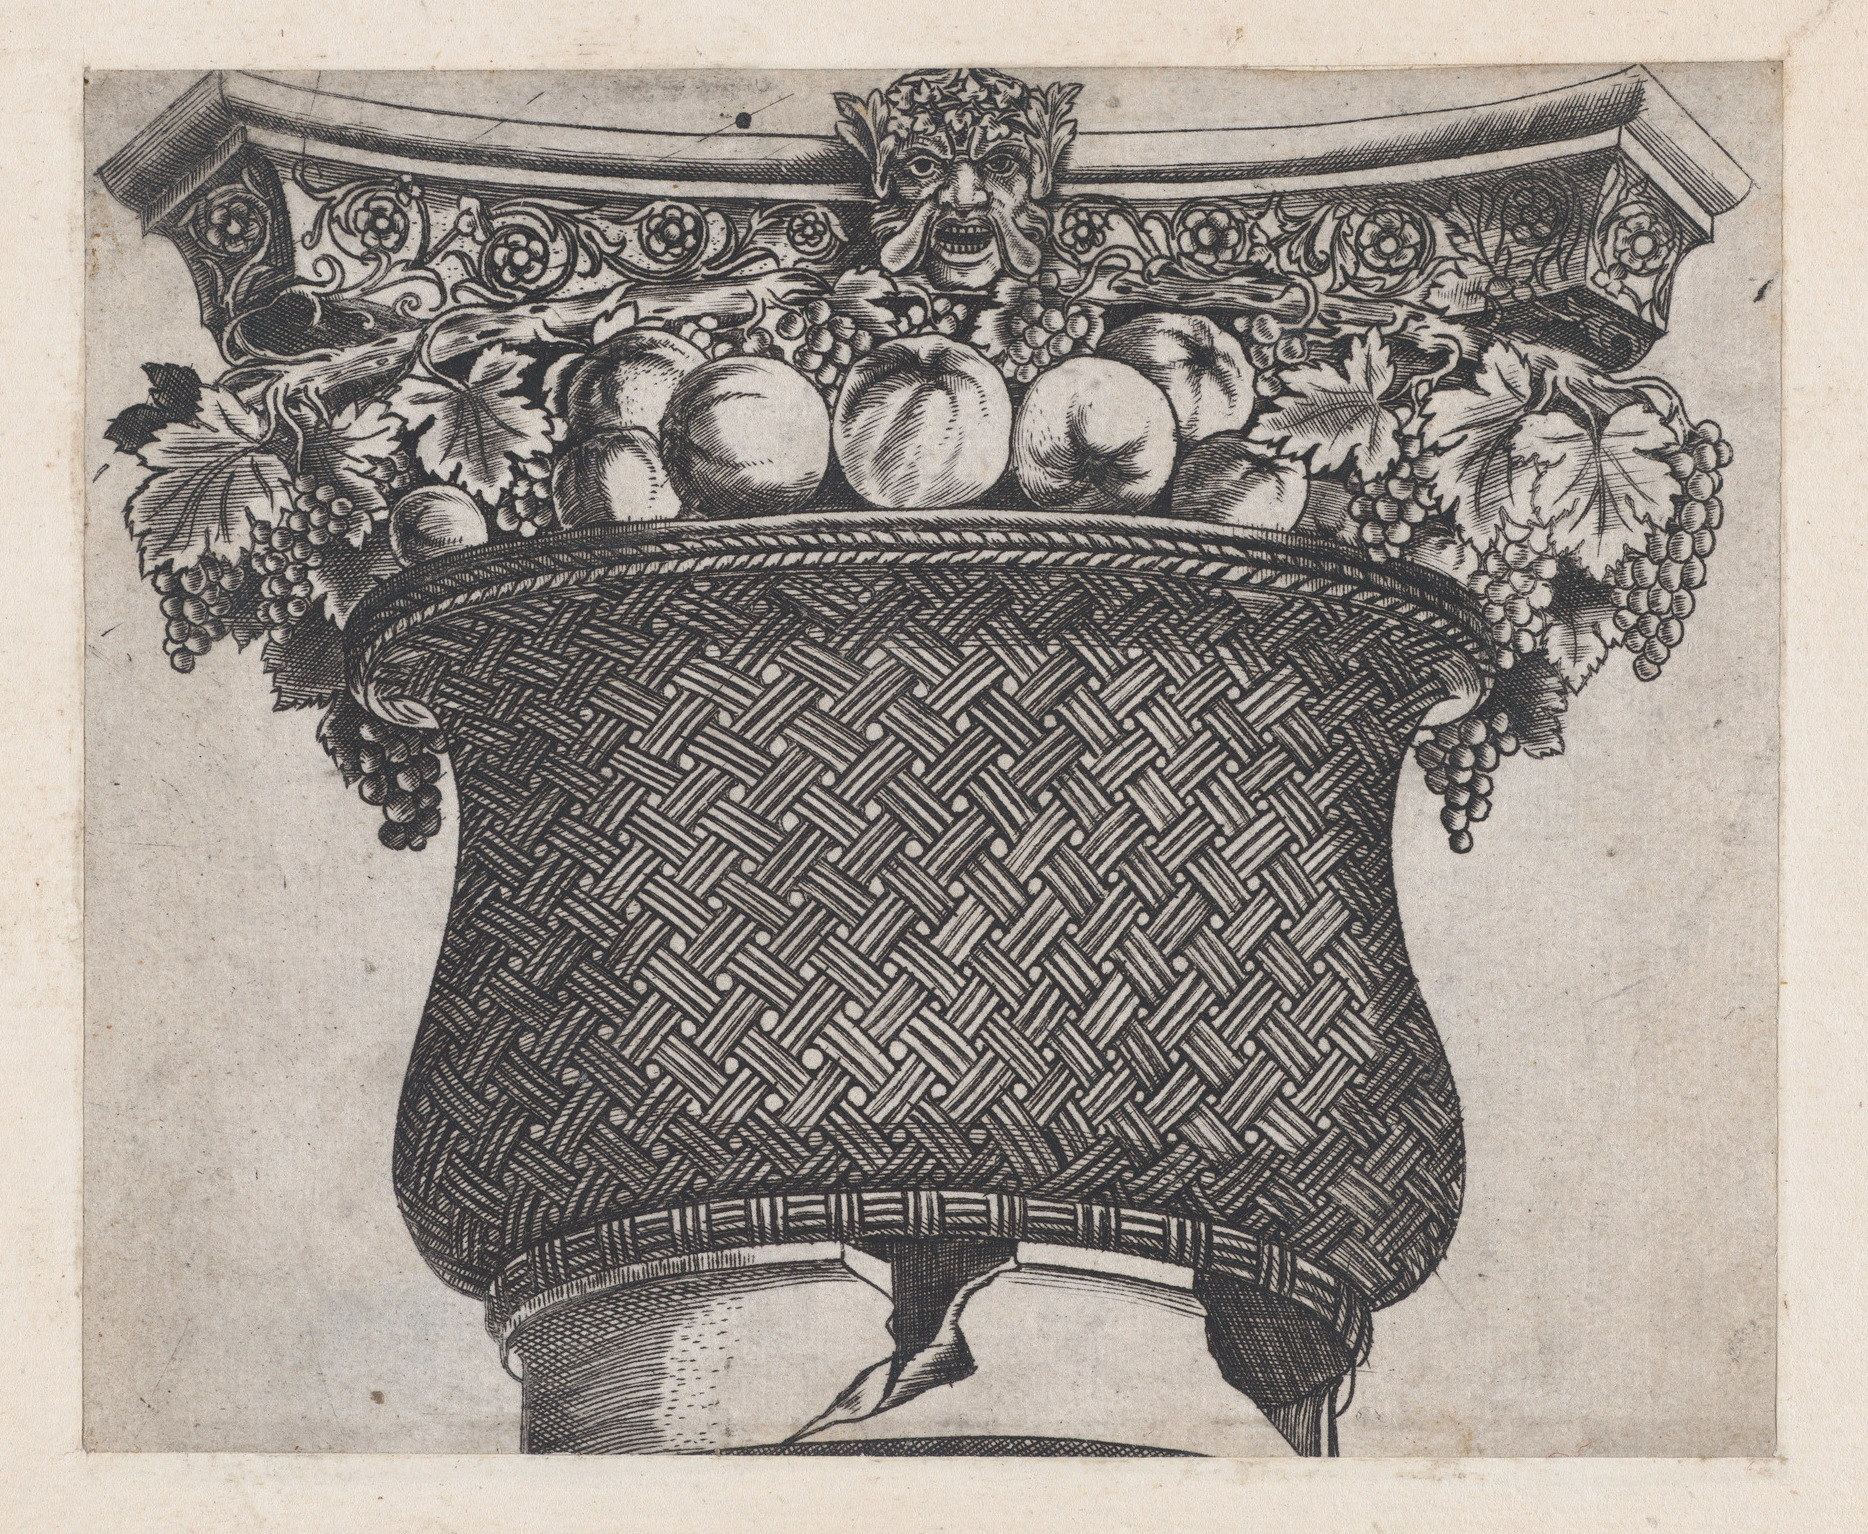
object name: print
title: Basket capital with fruit and satyr head, from "Speculum Romanae Magnificentiae"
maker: monogrammist g.a. with the caltrop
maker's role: artist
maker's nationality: italian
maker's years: 1535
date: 1537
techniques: engraving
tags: capitals,fruit,satyrs